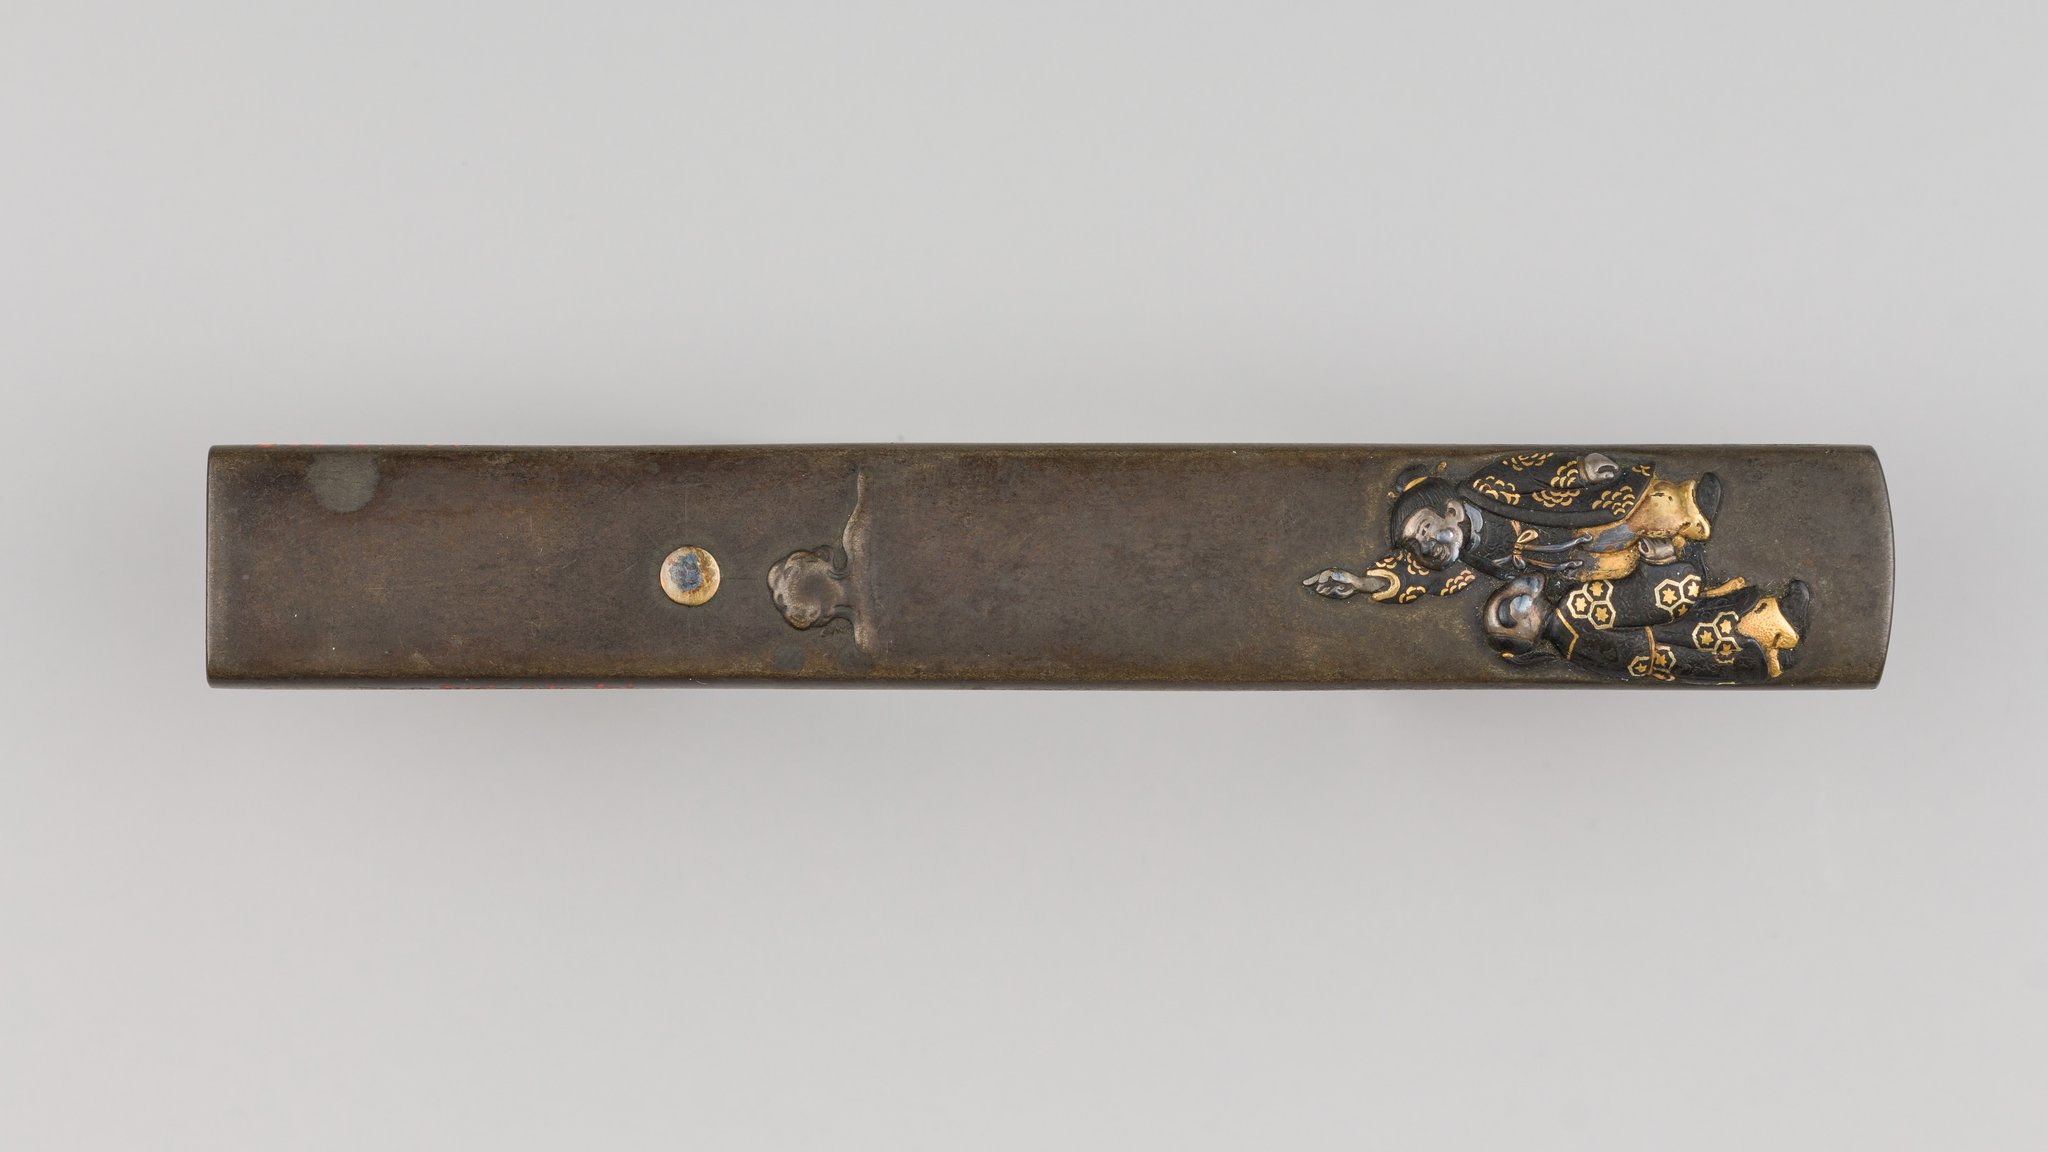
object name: knife handle kozuka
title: Knife Handle (Kozuka)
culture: japanese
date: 1801-1900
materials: silver alloy, gold, silver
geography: japan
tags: men